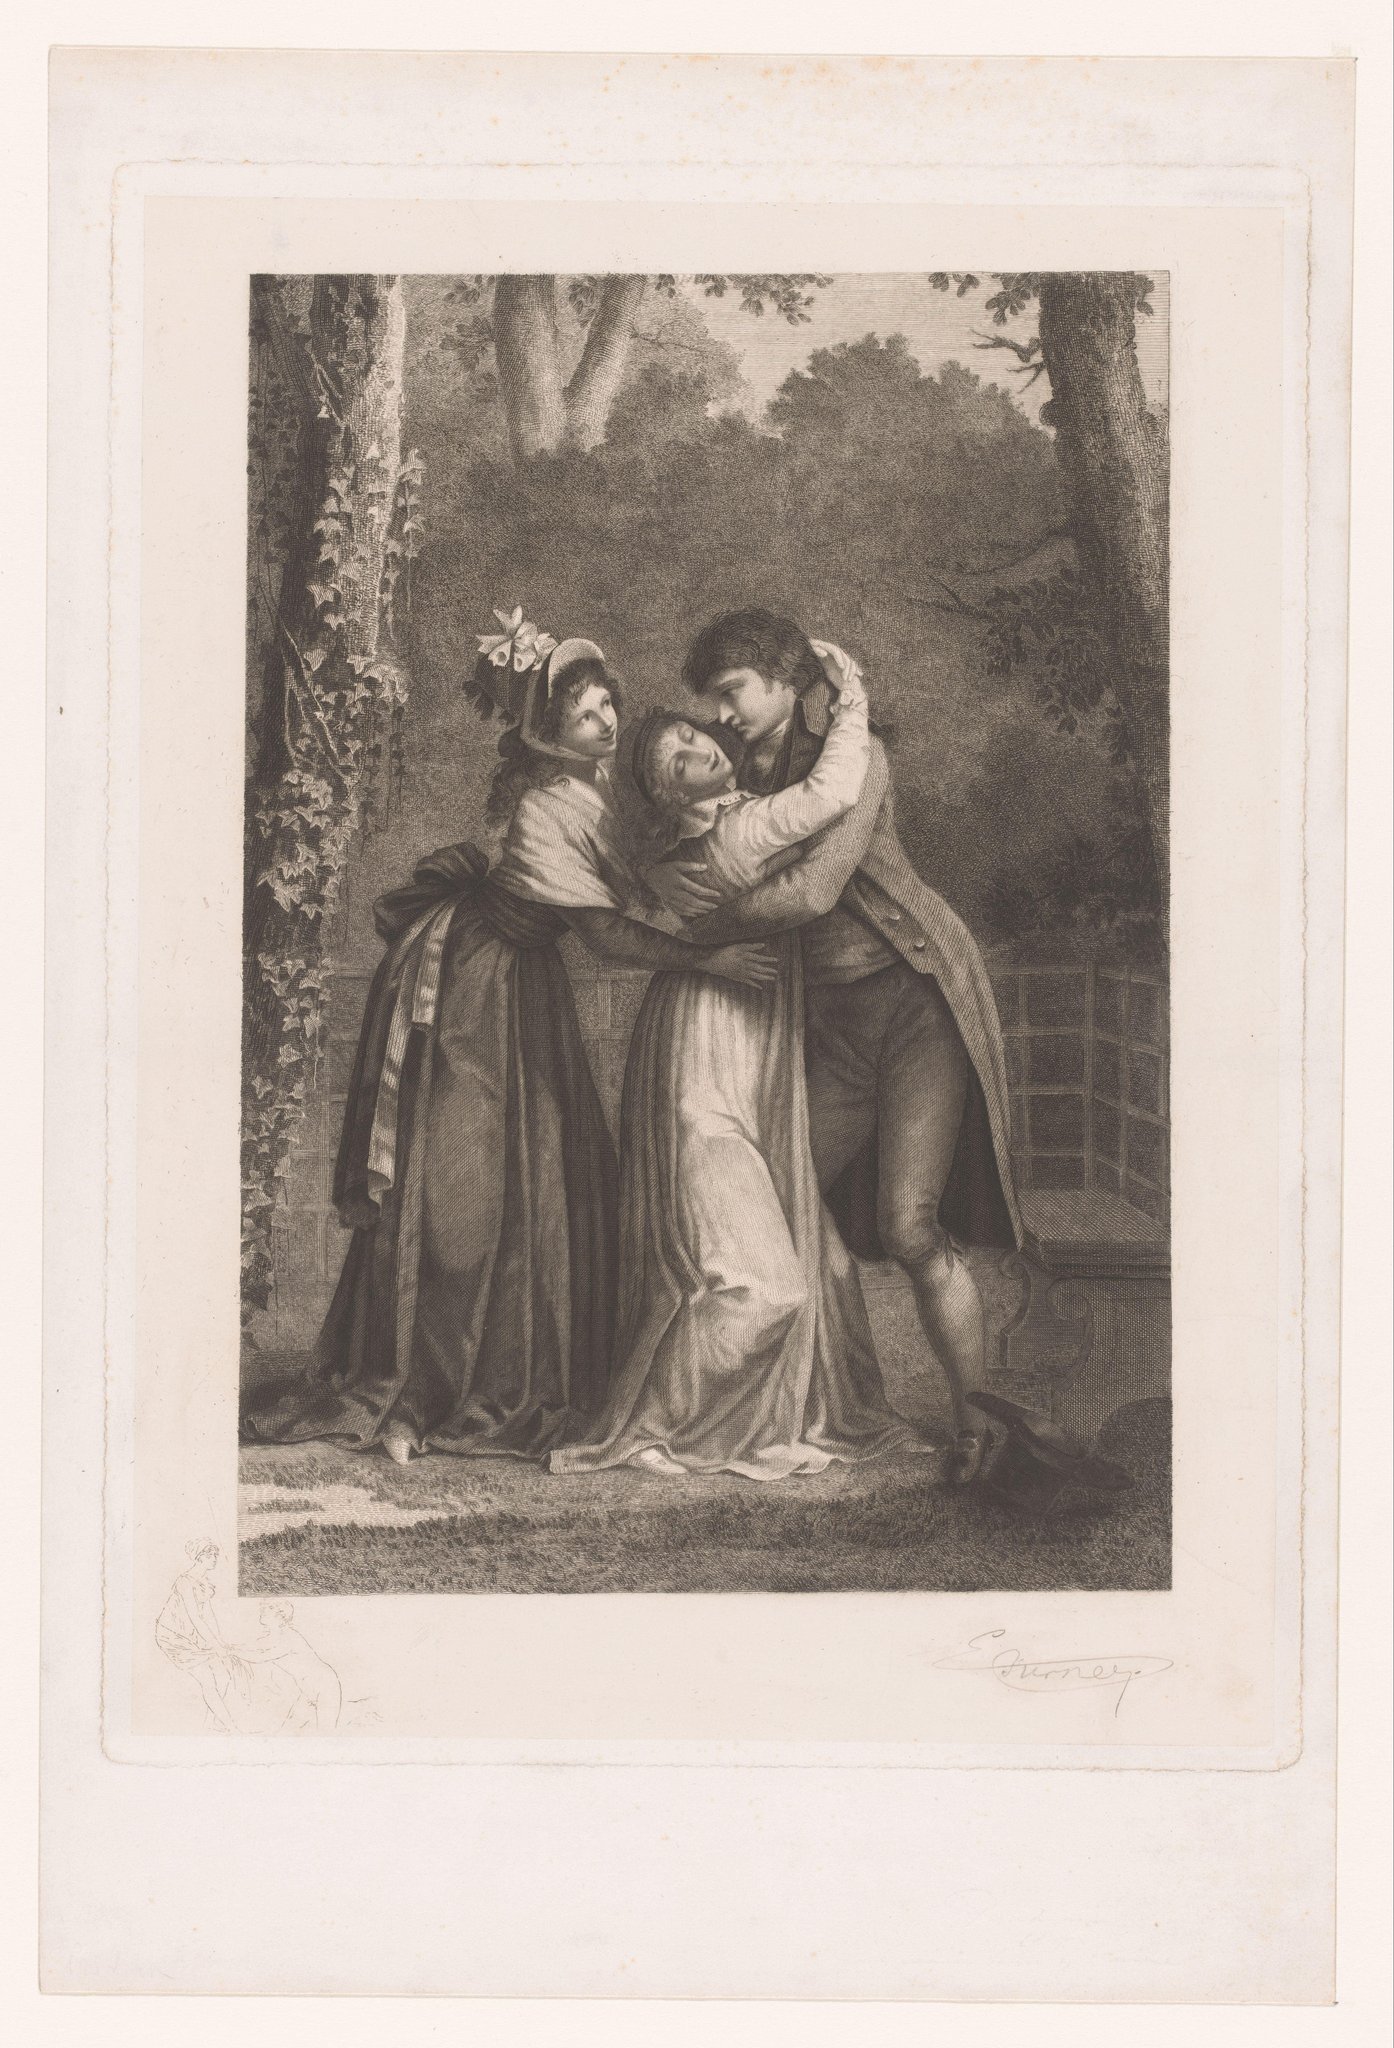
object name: print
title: Eerste kus van Julie en Saint-Preux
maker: e. burney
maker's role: print maker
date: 1840-1900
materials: paper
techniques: engraving, etching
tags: (lovers) kissing each other, literary characters and objects, daphnis (in greek mythology a shepherd who invented pastoral poetry, chloe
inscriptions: collector's mark: Lugt 2228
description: Scène uit "La nouvelle Heloïse" van Jean-Jacques Ruosseau. Onderaan in de marge een schets van Daphnis en Chloë, eveneens naar voorbeeld van Pierre Prud'hon.